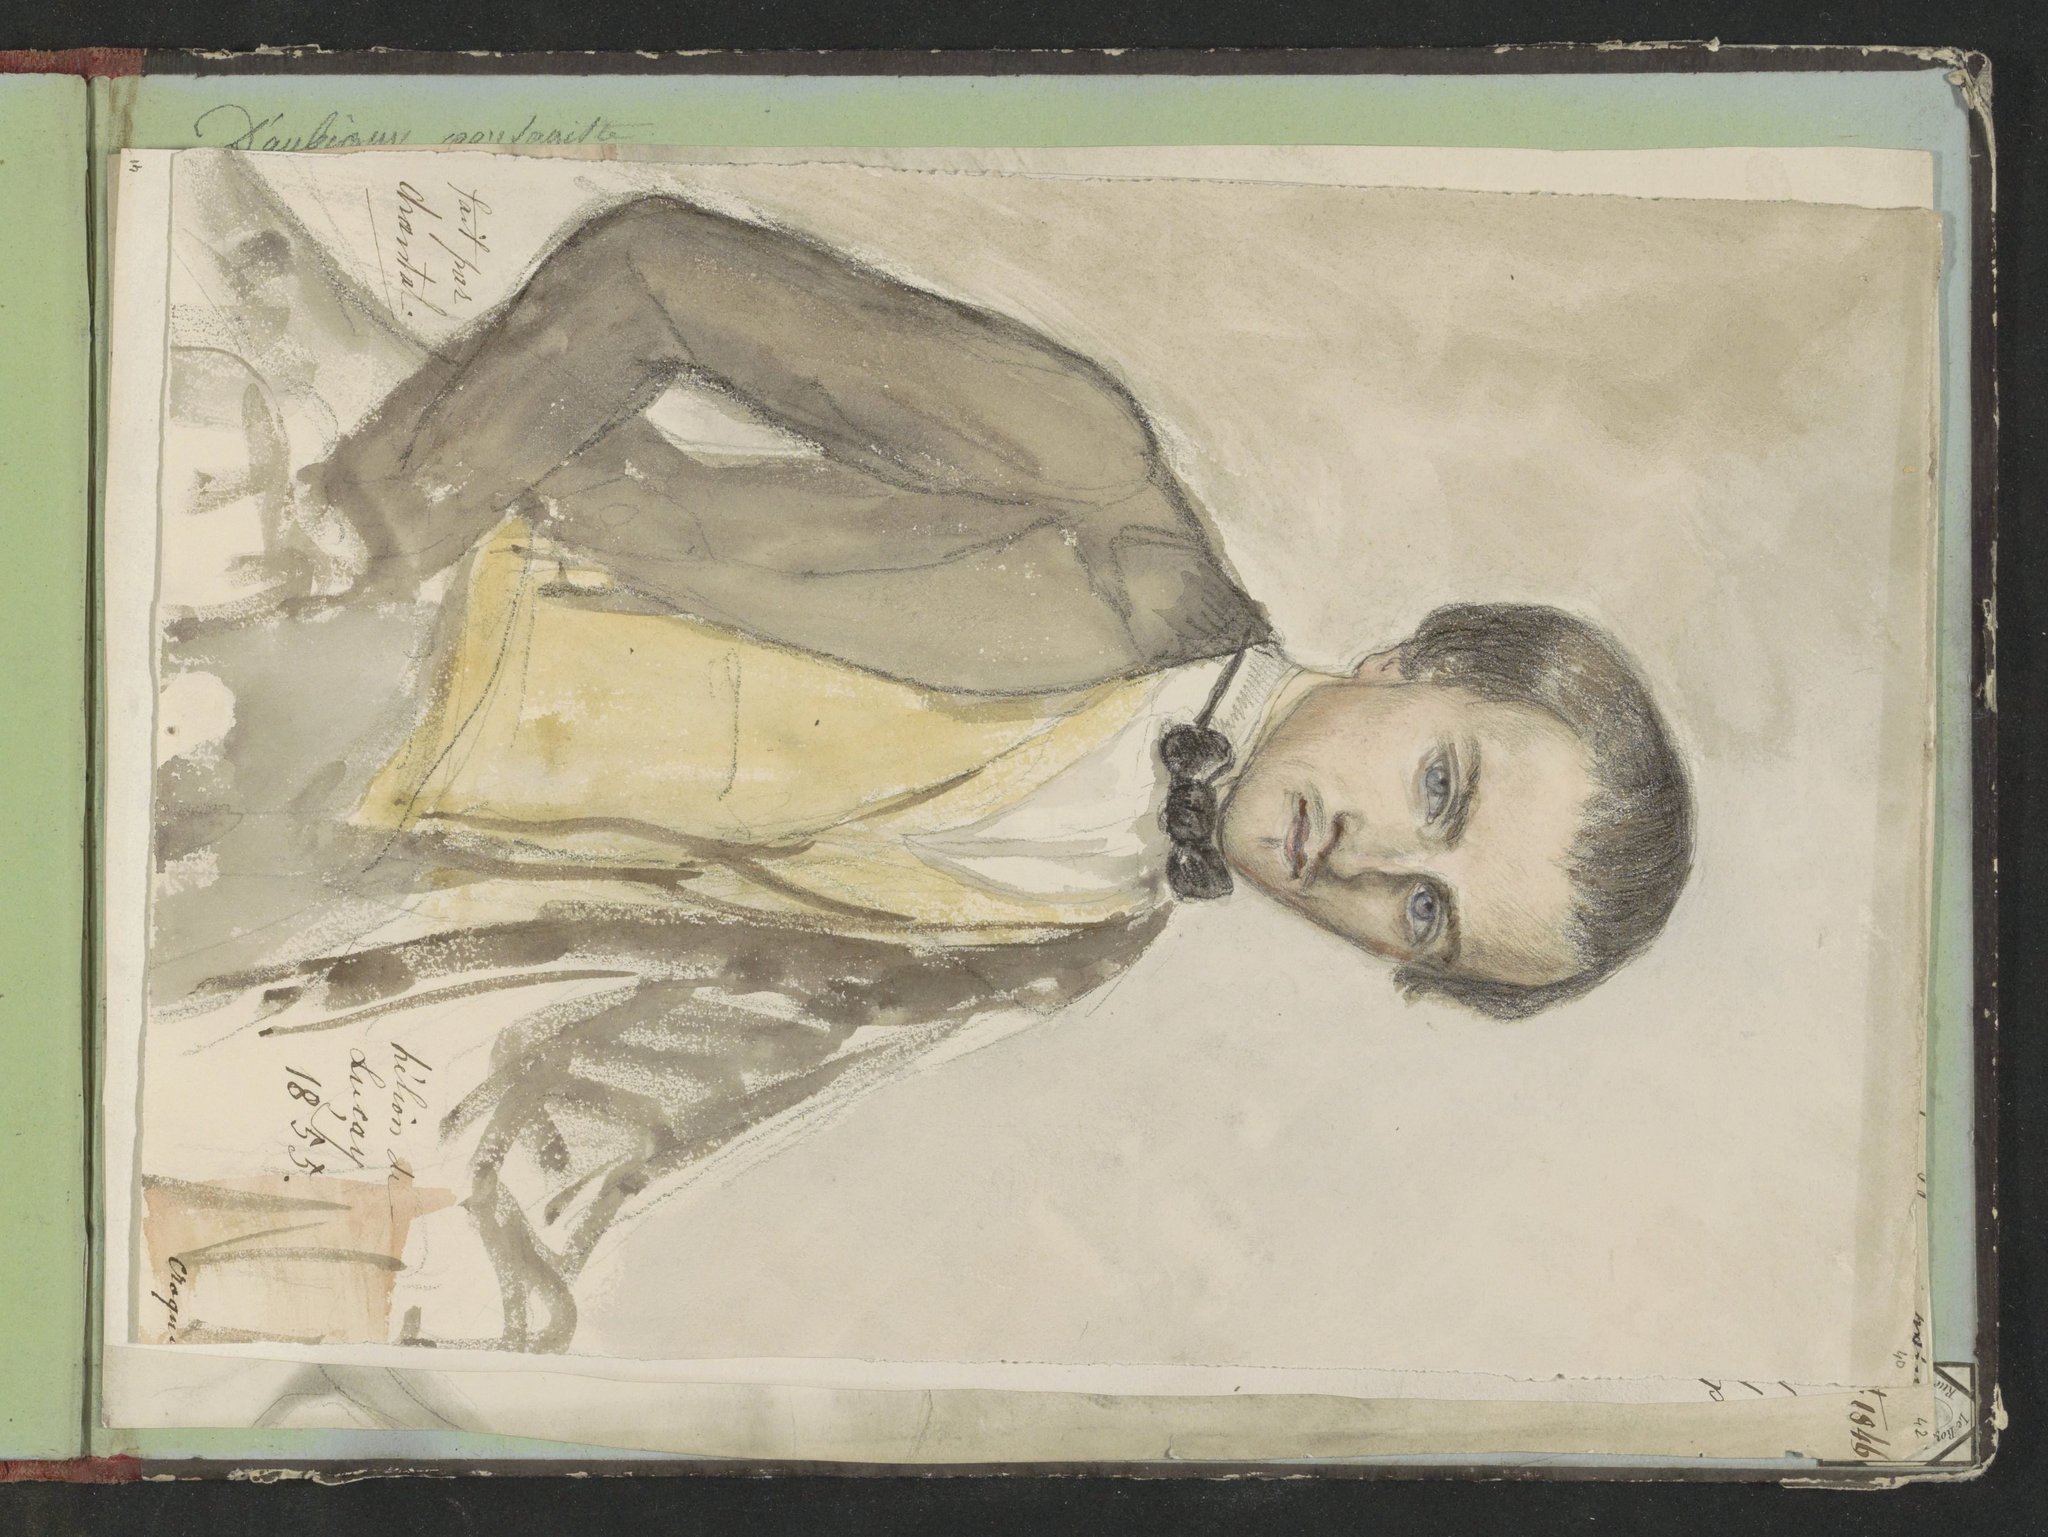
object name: sketchbook leaf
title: Portret van Hélion de Luçay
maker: chantal de luçay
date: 1855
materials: chalk, paper, pencil, watercolor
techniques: brush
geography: vineuil-saint-firmin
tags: paris, historical persons (portraits and scenes from the life)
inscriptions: name: ‘fait par/ chantal.’, date and inscription: ‘hélion de/ Lucay/ 1855/ croqu[...]’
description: Recto van blad 40, een losse tekening uit een schetsboek met 39 bladen.